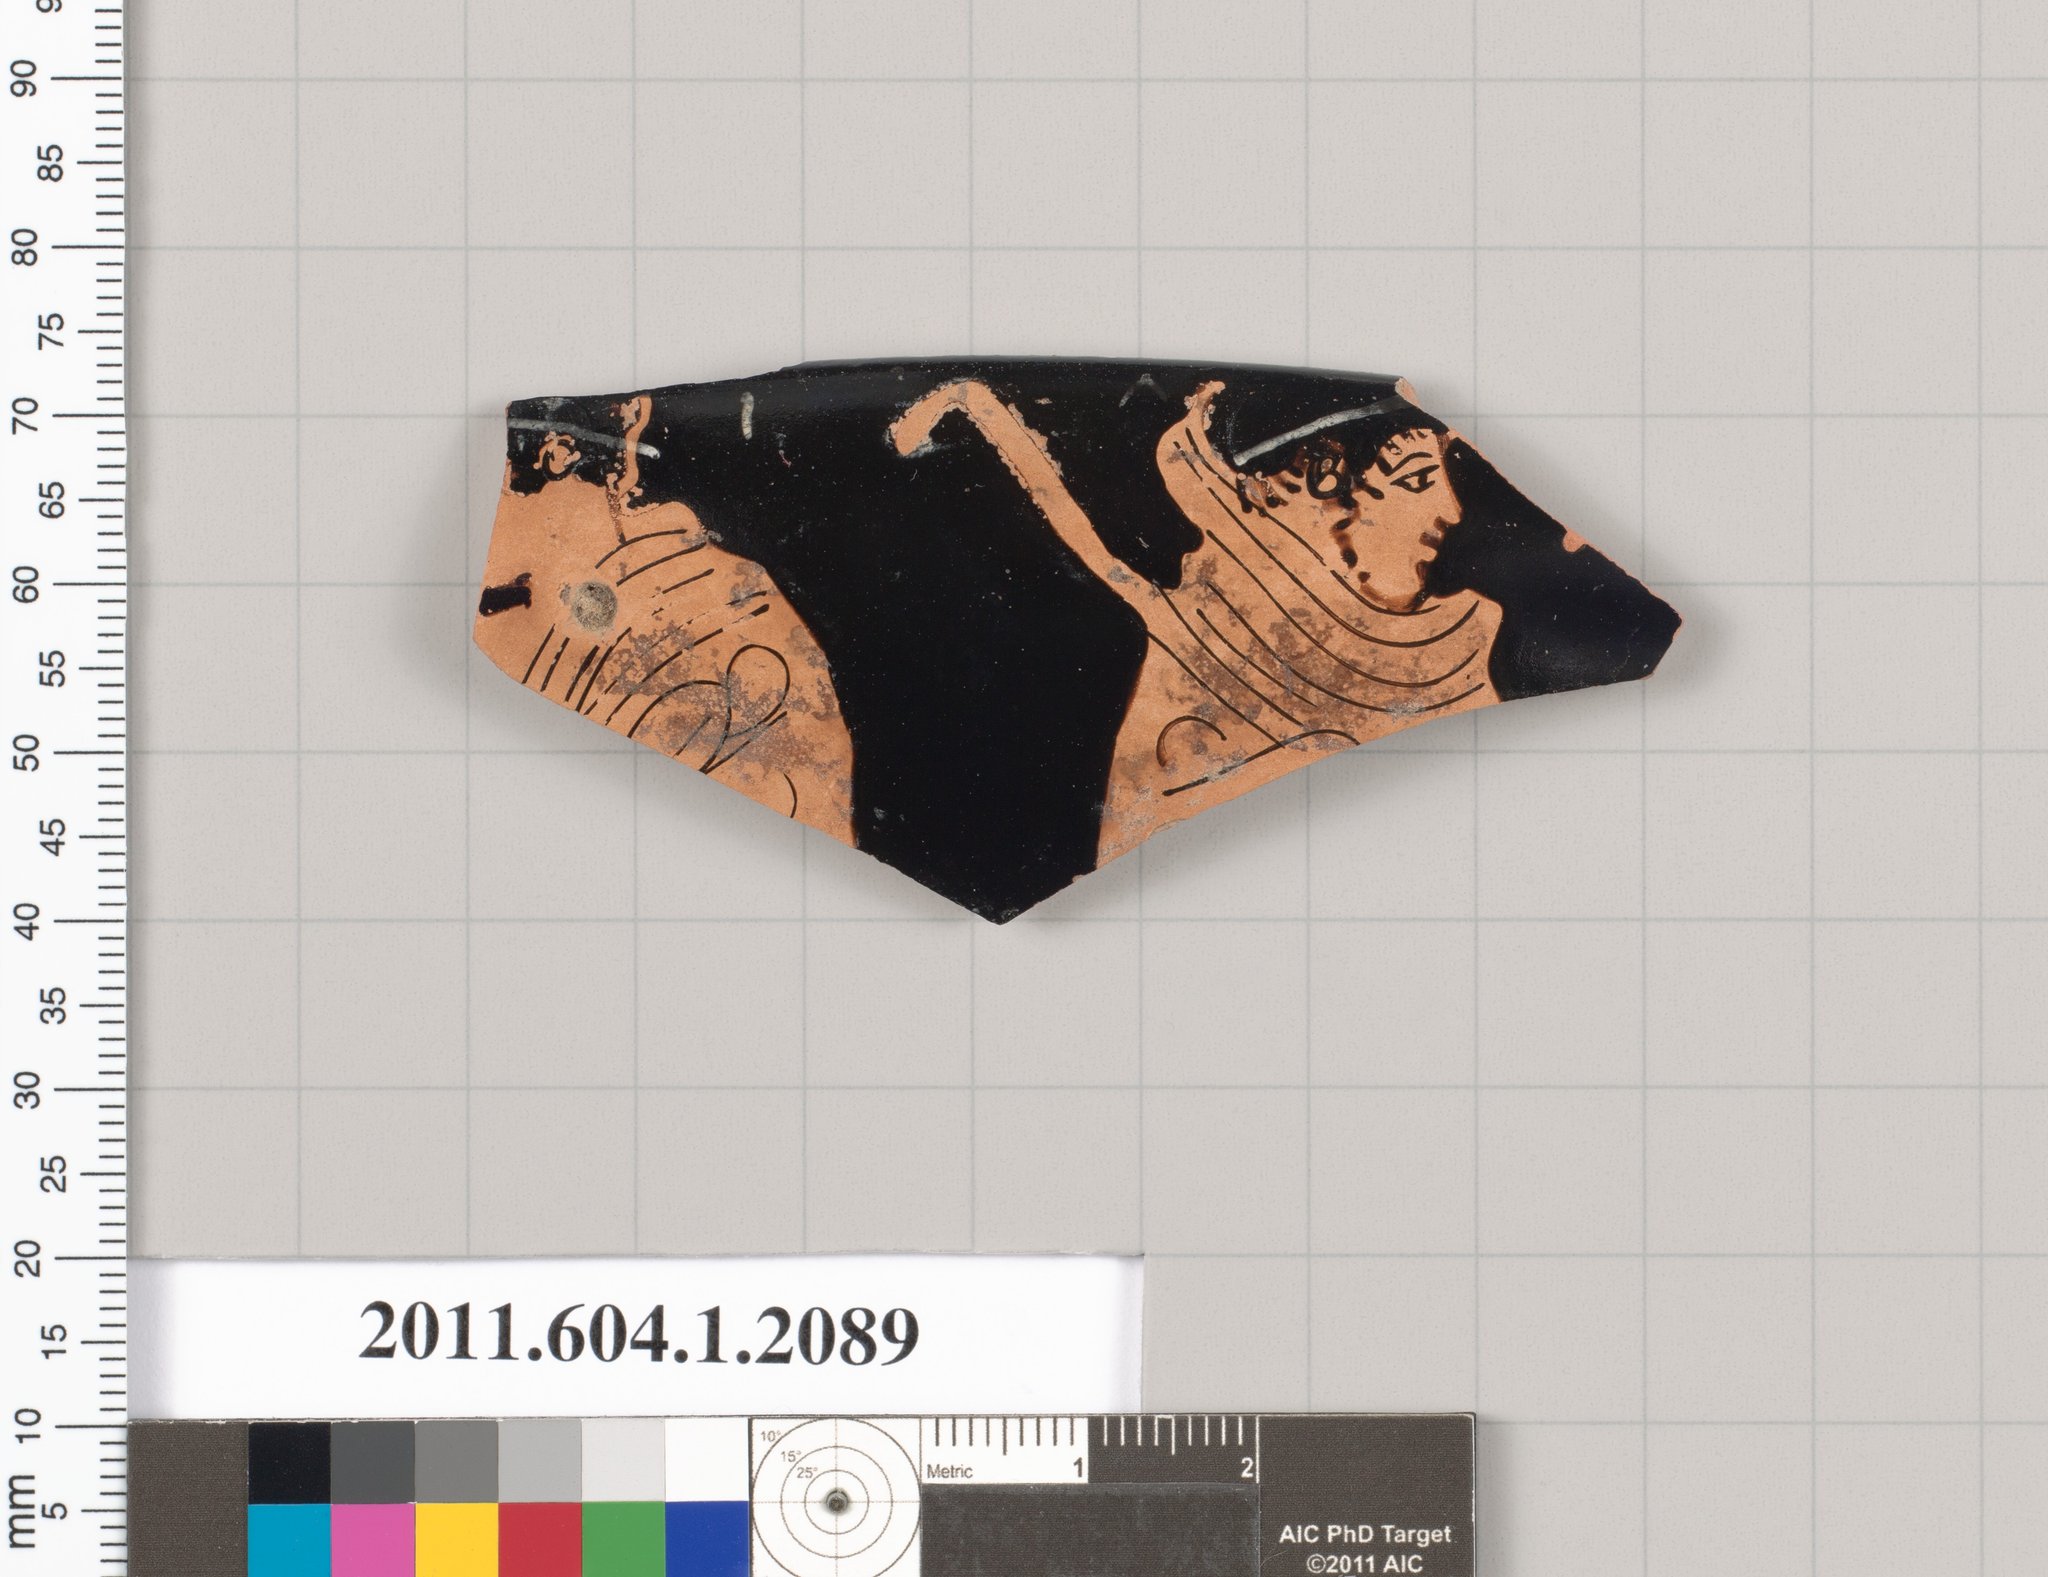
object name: kylix fragment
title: Terracotta rim fragment of a kylix (drinking cup)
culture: greek, attic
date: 460-450 BCE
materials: terracotta